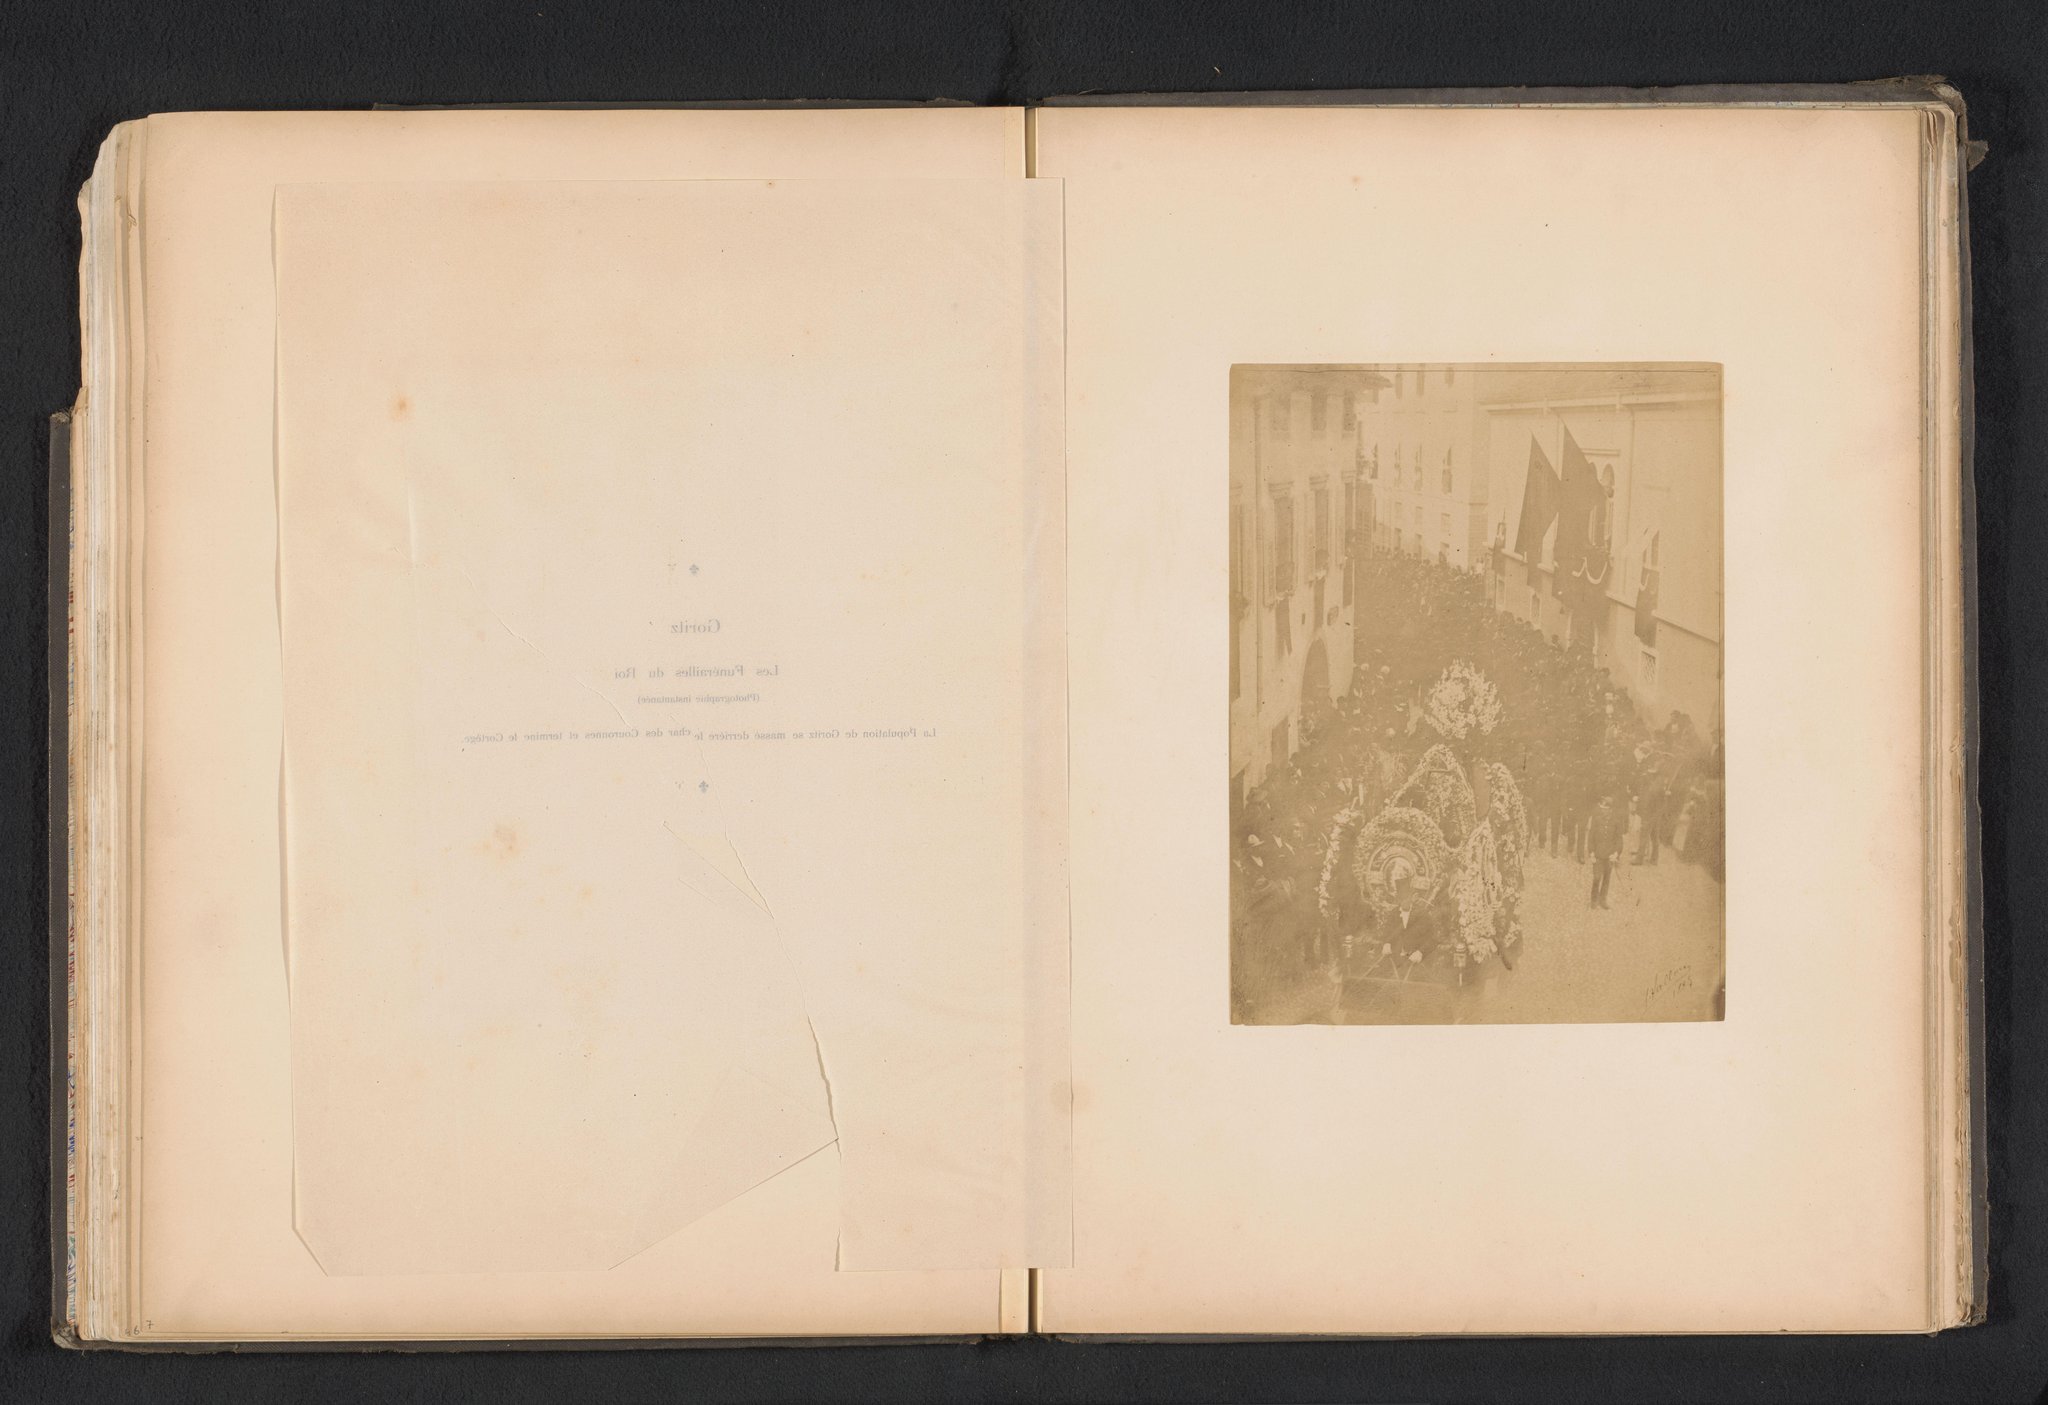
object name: photograph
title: Begrafenisstoet van Henri d'Artois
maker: a. vallois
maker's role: fotograaf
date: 1878-1883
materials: photographic support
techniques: albumen print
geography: göritz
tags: cortege, funeral procession